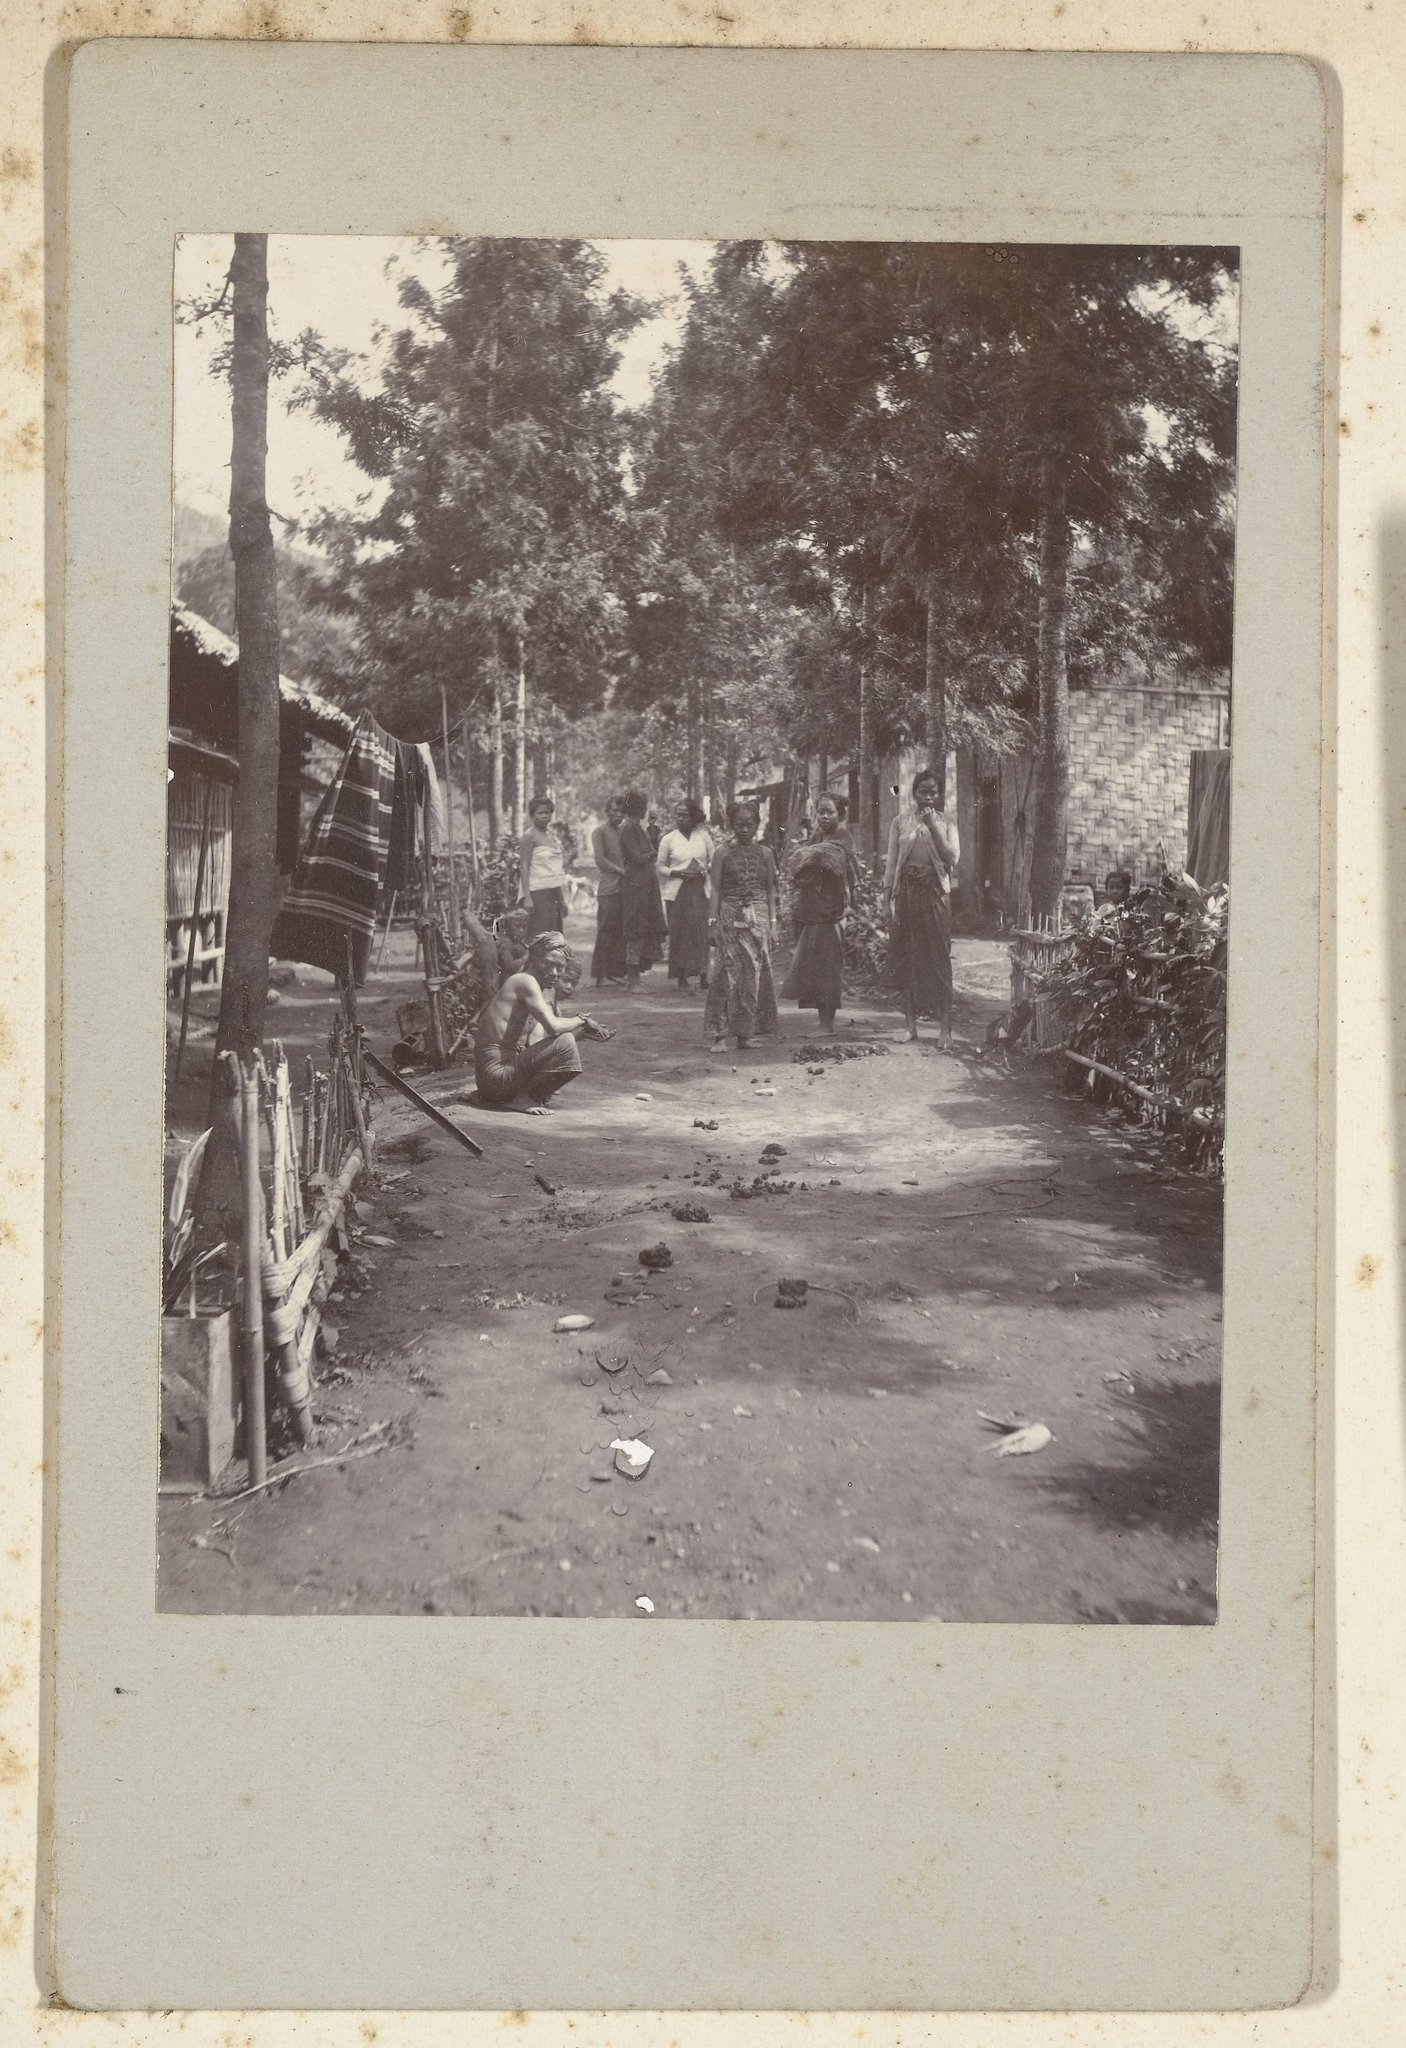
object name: photograph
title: Huizen op het fabrieksterrein van Silo Sanen in Indoensië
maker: Anonymous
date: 1890-1910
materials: cardboard, paper, photographic support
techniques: gelatin silver print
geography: indonesia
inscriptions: title: ‘N 4. silo Sanen. Gedeelte van de kampong van buren gezien. Steeds een kant van den weg re zien wegens guerilla bomen links. Kale dadep.. alouan in den achtergrond. Noties zinken daken op de huizen.’